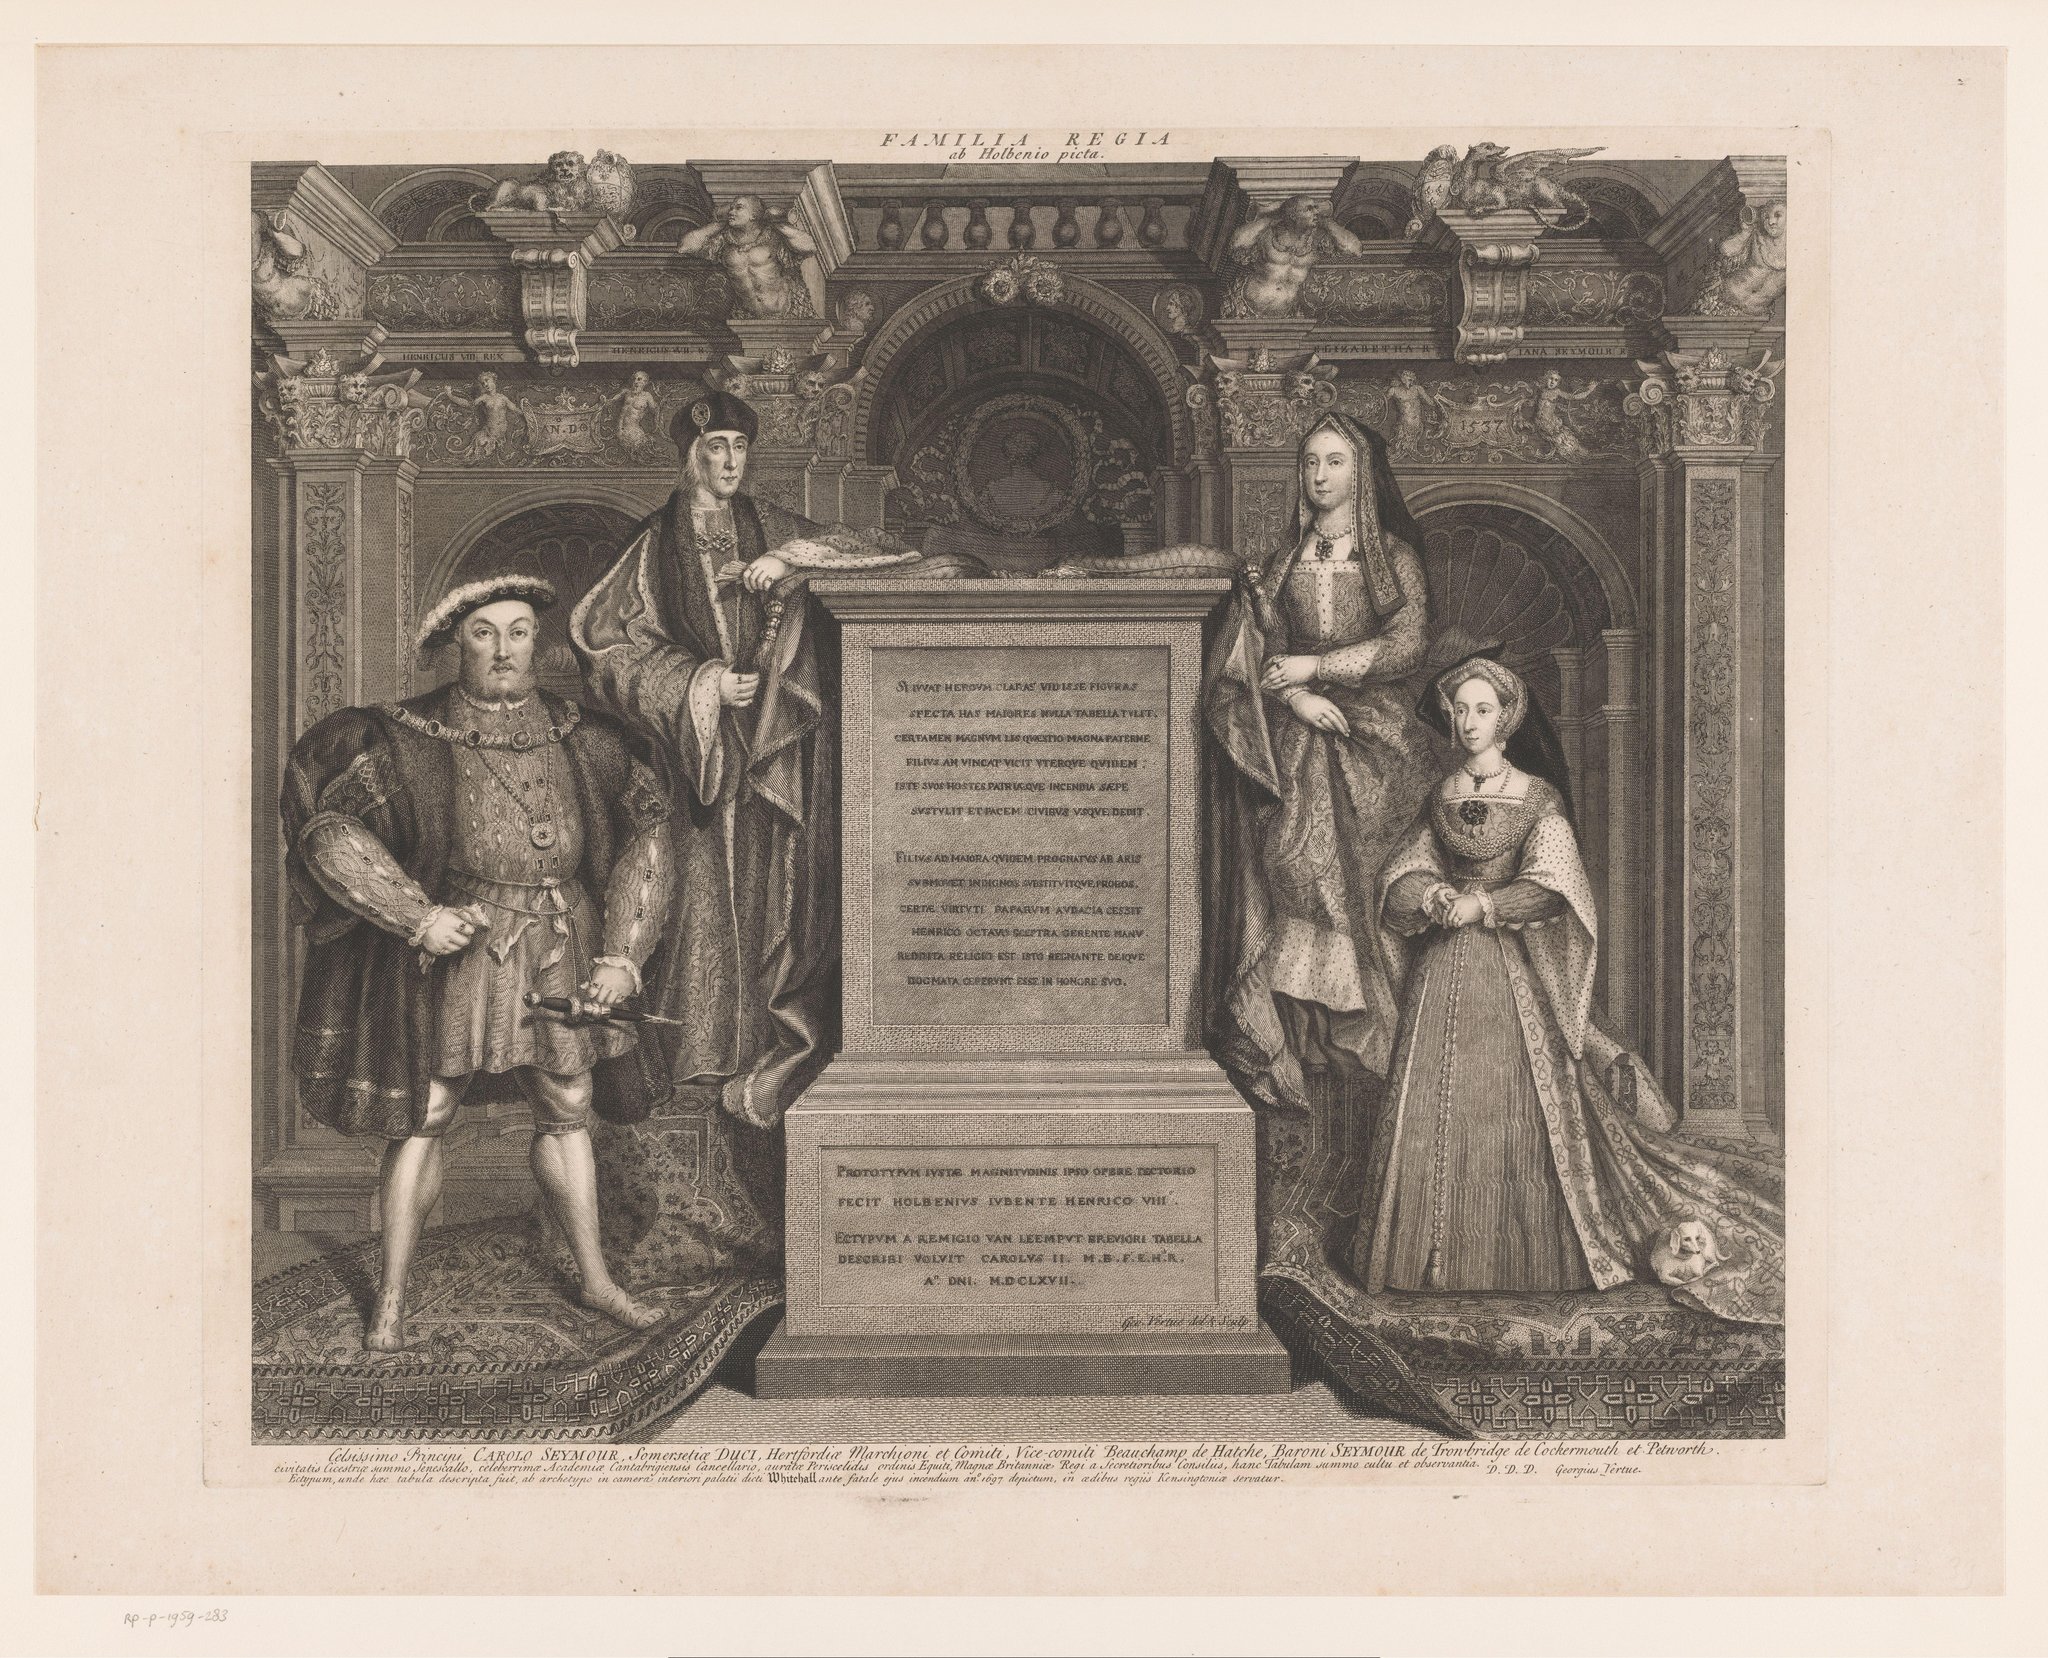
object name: print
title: Familia Regia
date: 1743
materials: paper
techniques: engraving, etching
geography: london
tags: historical persons, queen, pearl; pearl necklace, balustrade, king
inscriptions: collector's mark: Lugt 2760, collector's mark: Lugt 2228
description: Prent hoort bij een serie van negen prenten naar portretten van de Tudor-familie. De eerste vier werden in 1743 uitgegeven. In 1748 werden weer vier prenten gepubliceerd en in 1750 een laatste.